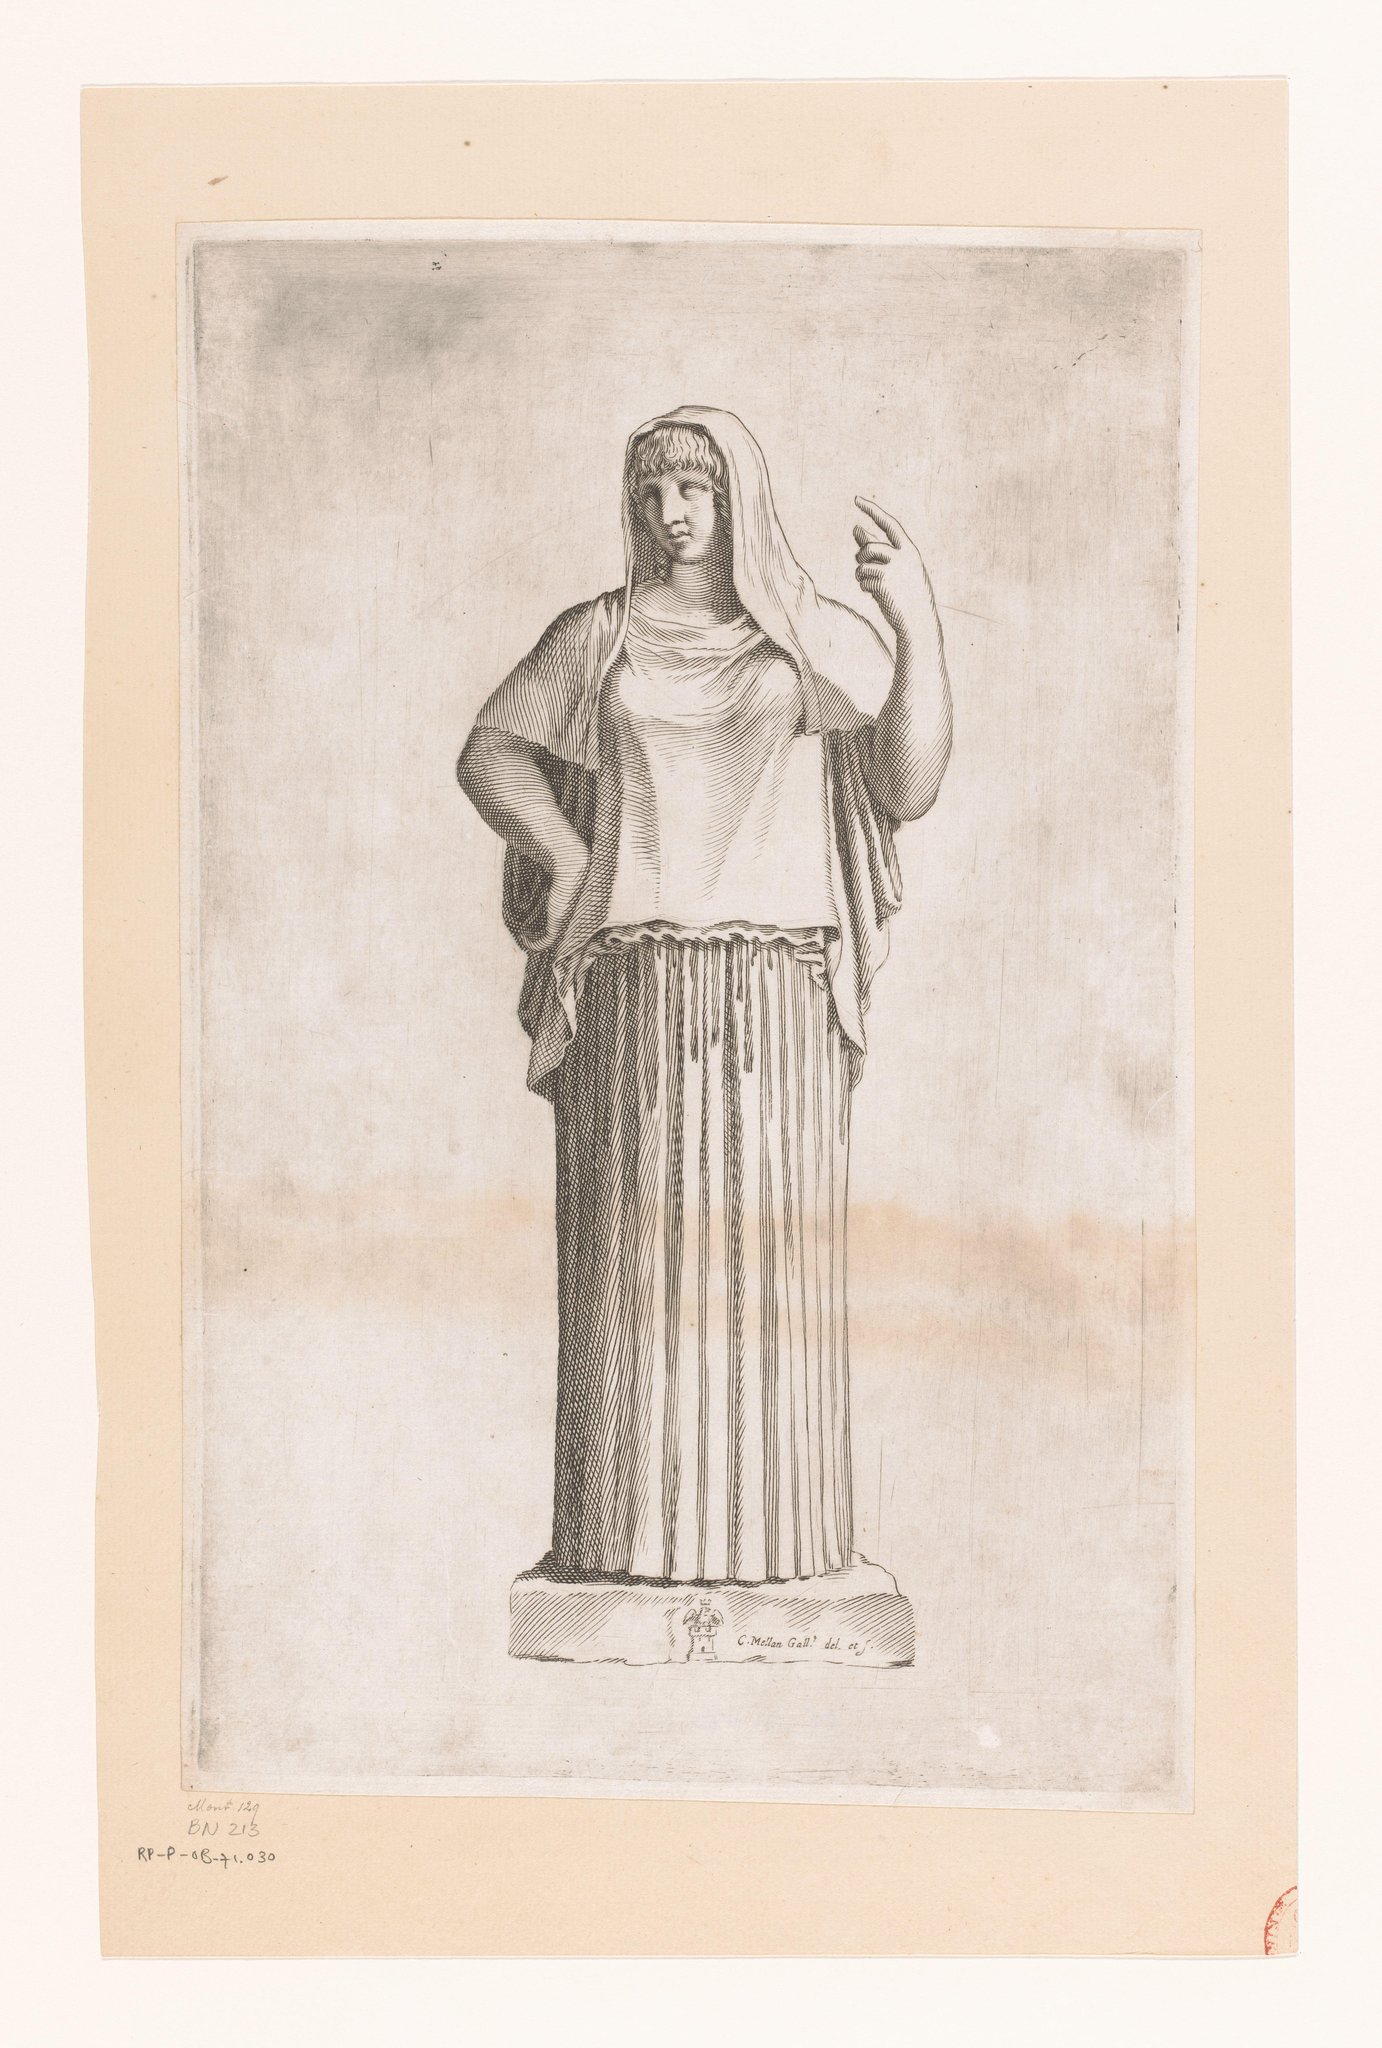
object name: print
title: Galleria Giustiniana del Marchese Vincenzo Giustiniani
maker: claude mellan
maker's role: draughtsman, print maker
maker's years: 1598-1688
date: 1631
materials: paper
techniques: engraving, intaglio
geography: rome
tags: vincenzo giustiniani (1564-1637), vestal virgin(s), piece of sculpture, reproduction of a piece of sculpture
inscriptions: collector's mark: Lugt 240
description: Maakt deel uit van een serie bestaande uit 322 prenten van kunstwerken uit de collectie van Vincenzo Giustiniani die in twee volumes werd uitgegeven door Joachim von Sandrart in 1636 en 1637 (zie British Museum, inv.nr. 1851,1213.565). De serie bestaat uit prenten door verschillende kunstenaars zoals Cornelis Bloemaert, Theodore Matham, Pieter de Bailliu en Michel Natalis. Claude Mellan was verantwoordelijk voor 22 prenten van standbeelden en het 1631 gedateerde portret van Giustiniani.